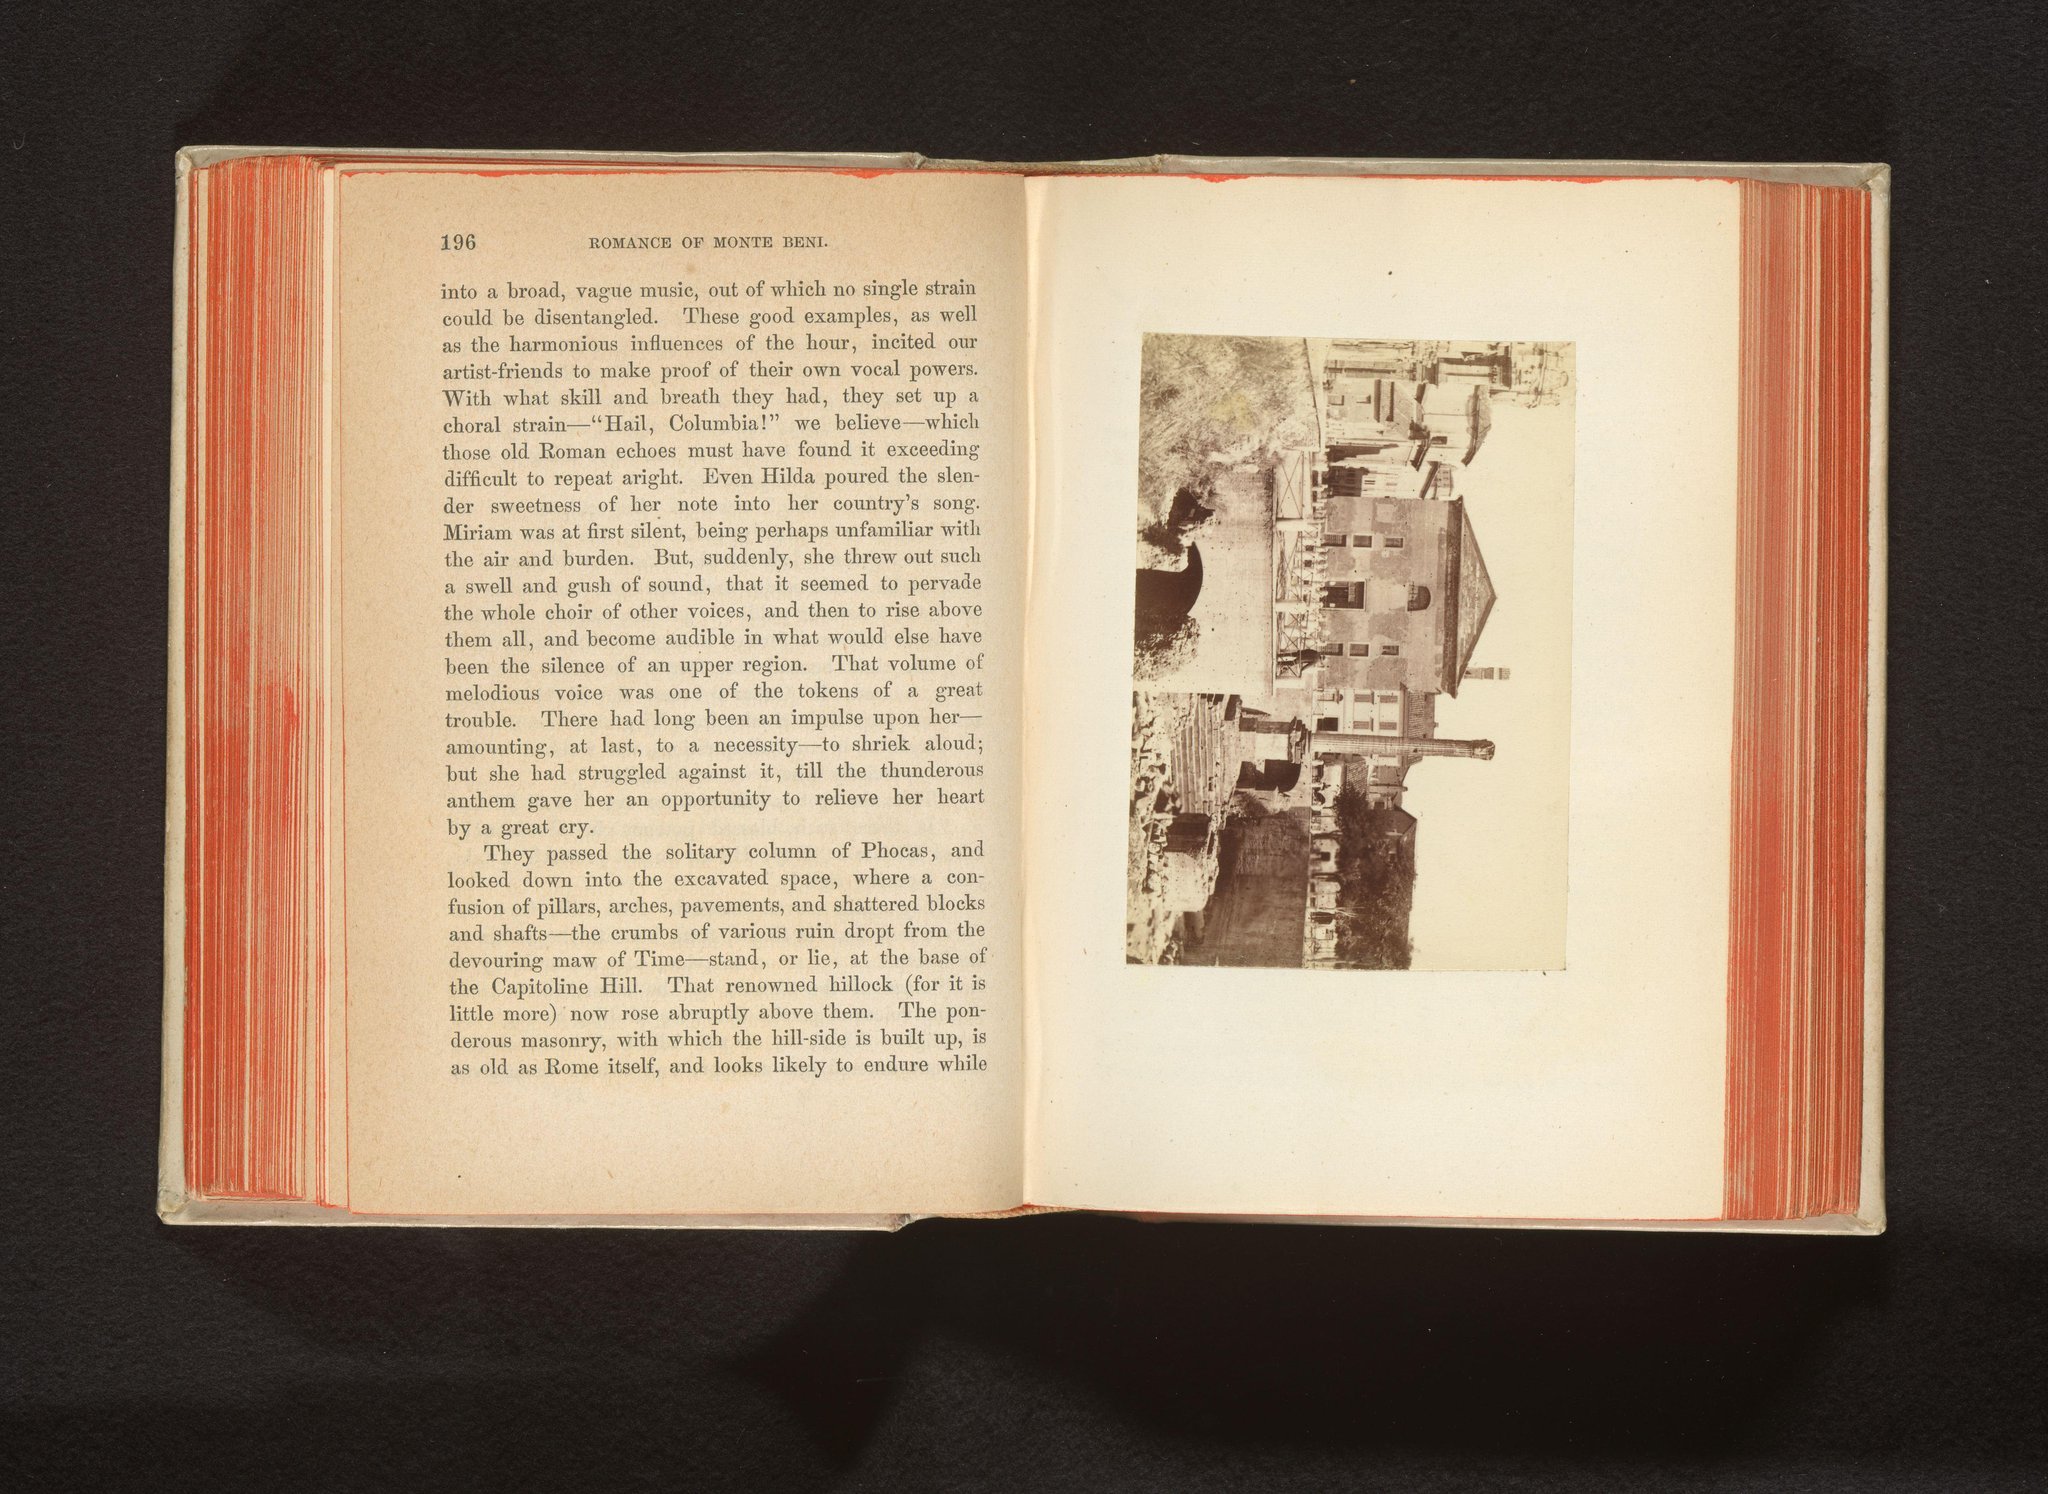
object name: photograph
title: Gezicht op de Zuil van Phocas op het Forum Romanum in Rome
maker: Anonymous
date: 1850-1860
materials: photographic support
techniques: albumen print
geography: rome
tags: column, pillar ~ architecture